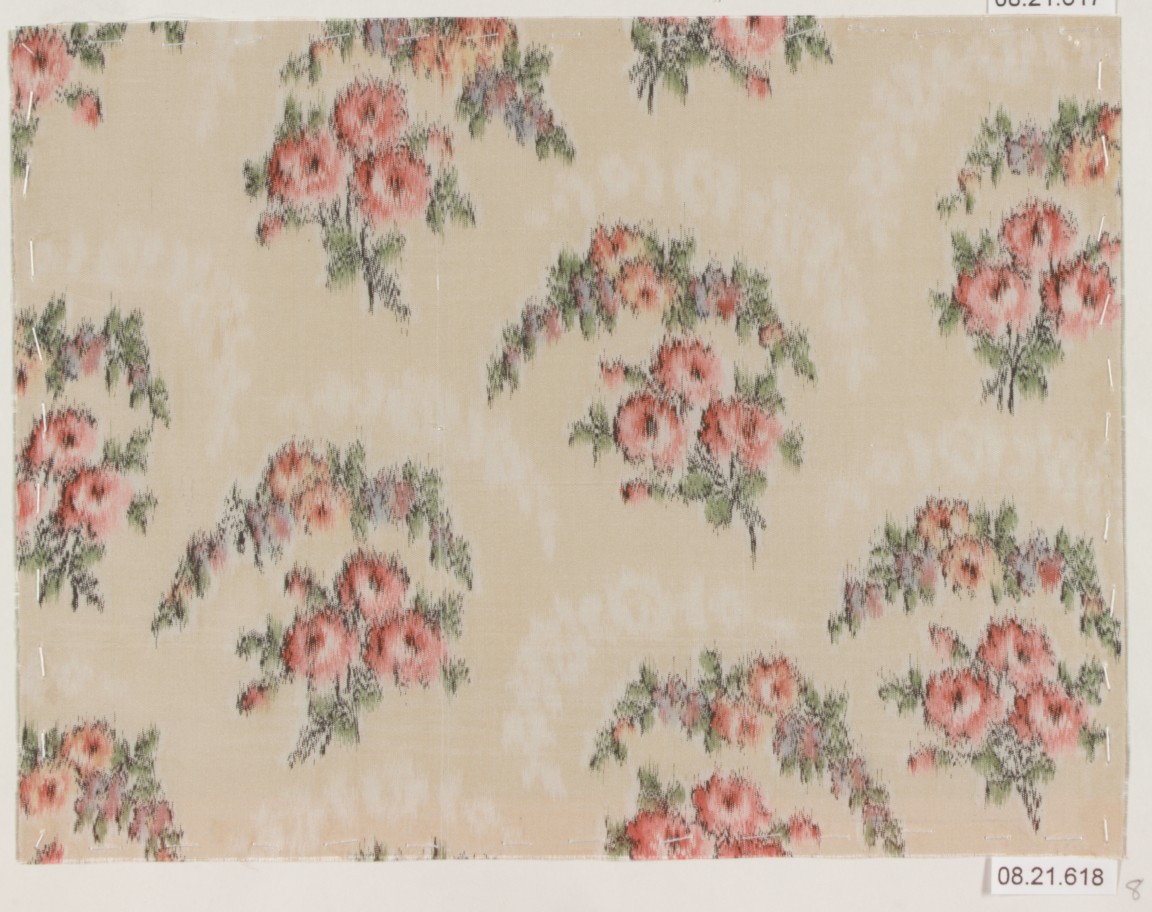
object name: textile sample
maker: Anonymous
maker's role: designer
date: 1900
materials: silk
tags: flowers